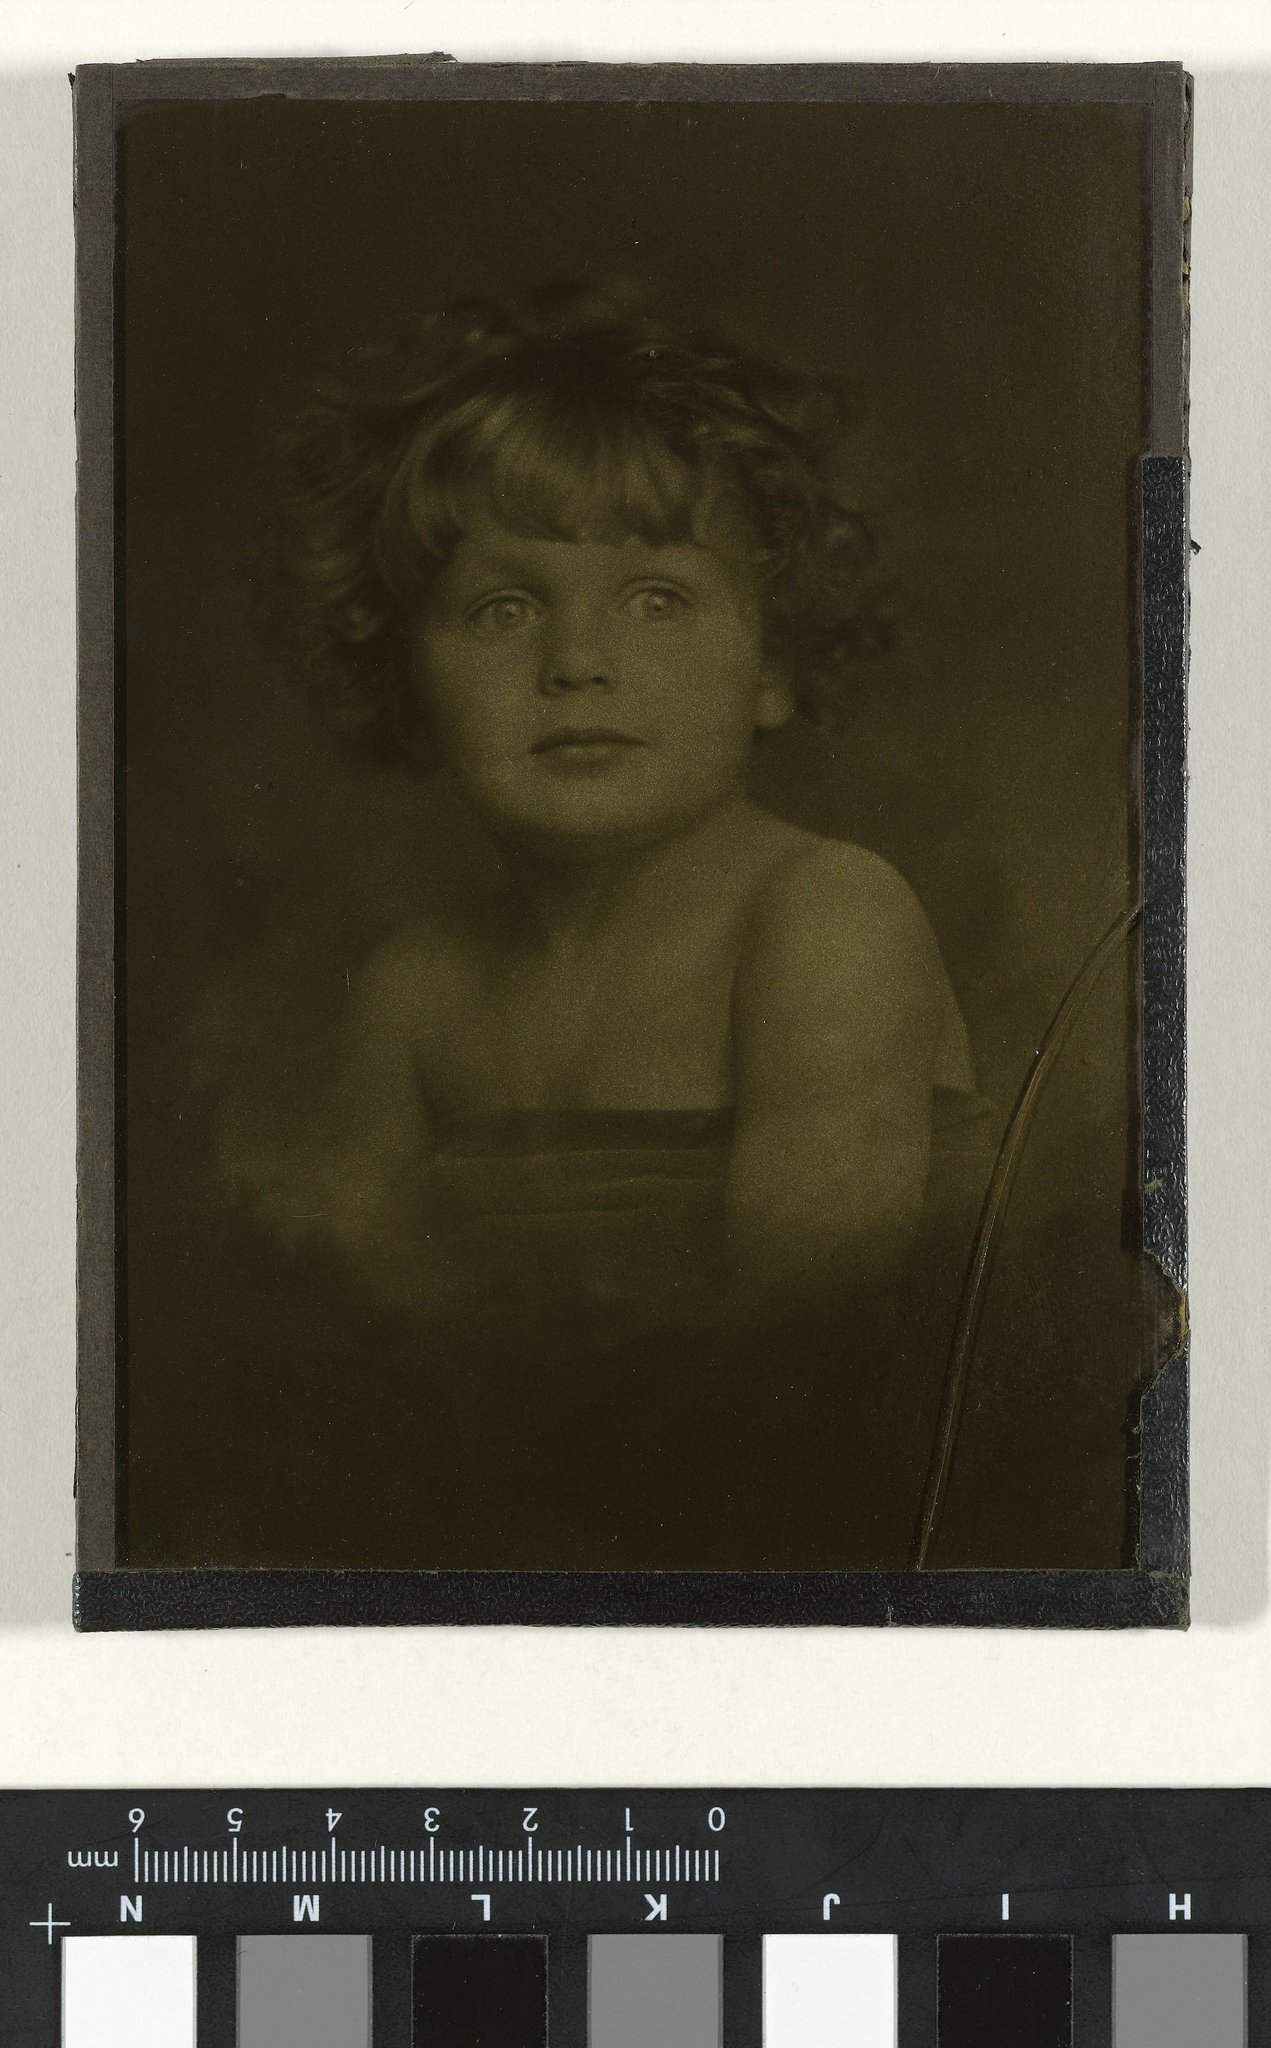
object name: photograph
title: Portret van een onbekend meisje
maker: jacob merkelbach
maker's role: fotograaf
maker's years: 1877-1942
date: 1893-1942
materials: cardboard, glass, metal, paper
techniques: orotone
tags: historical persons not known by name - bb - woman, girl (child between toddler and youth)